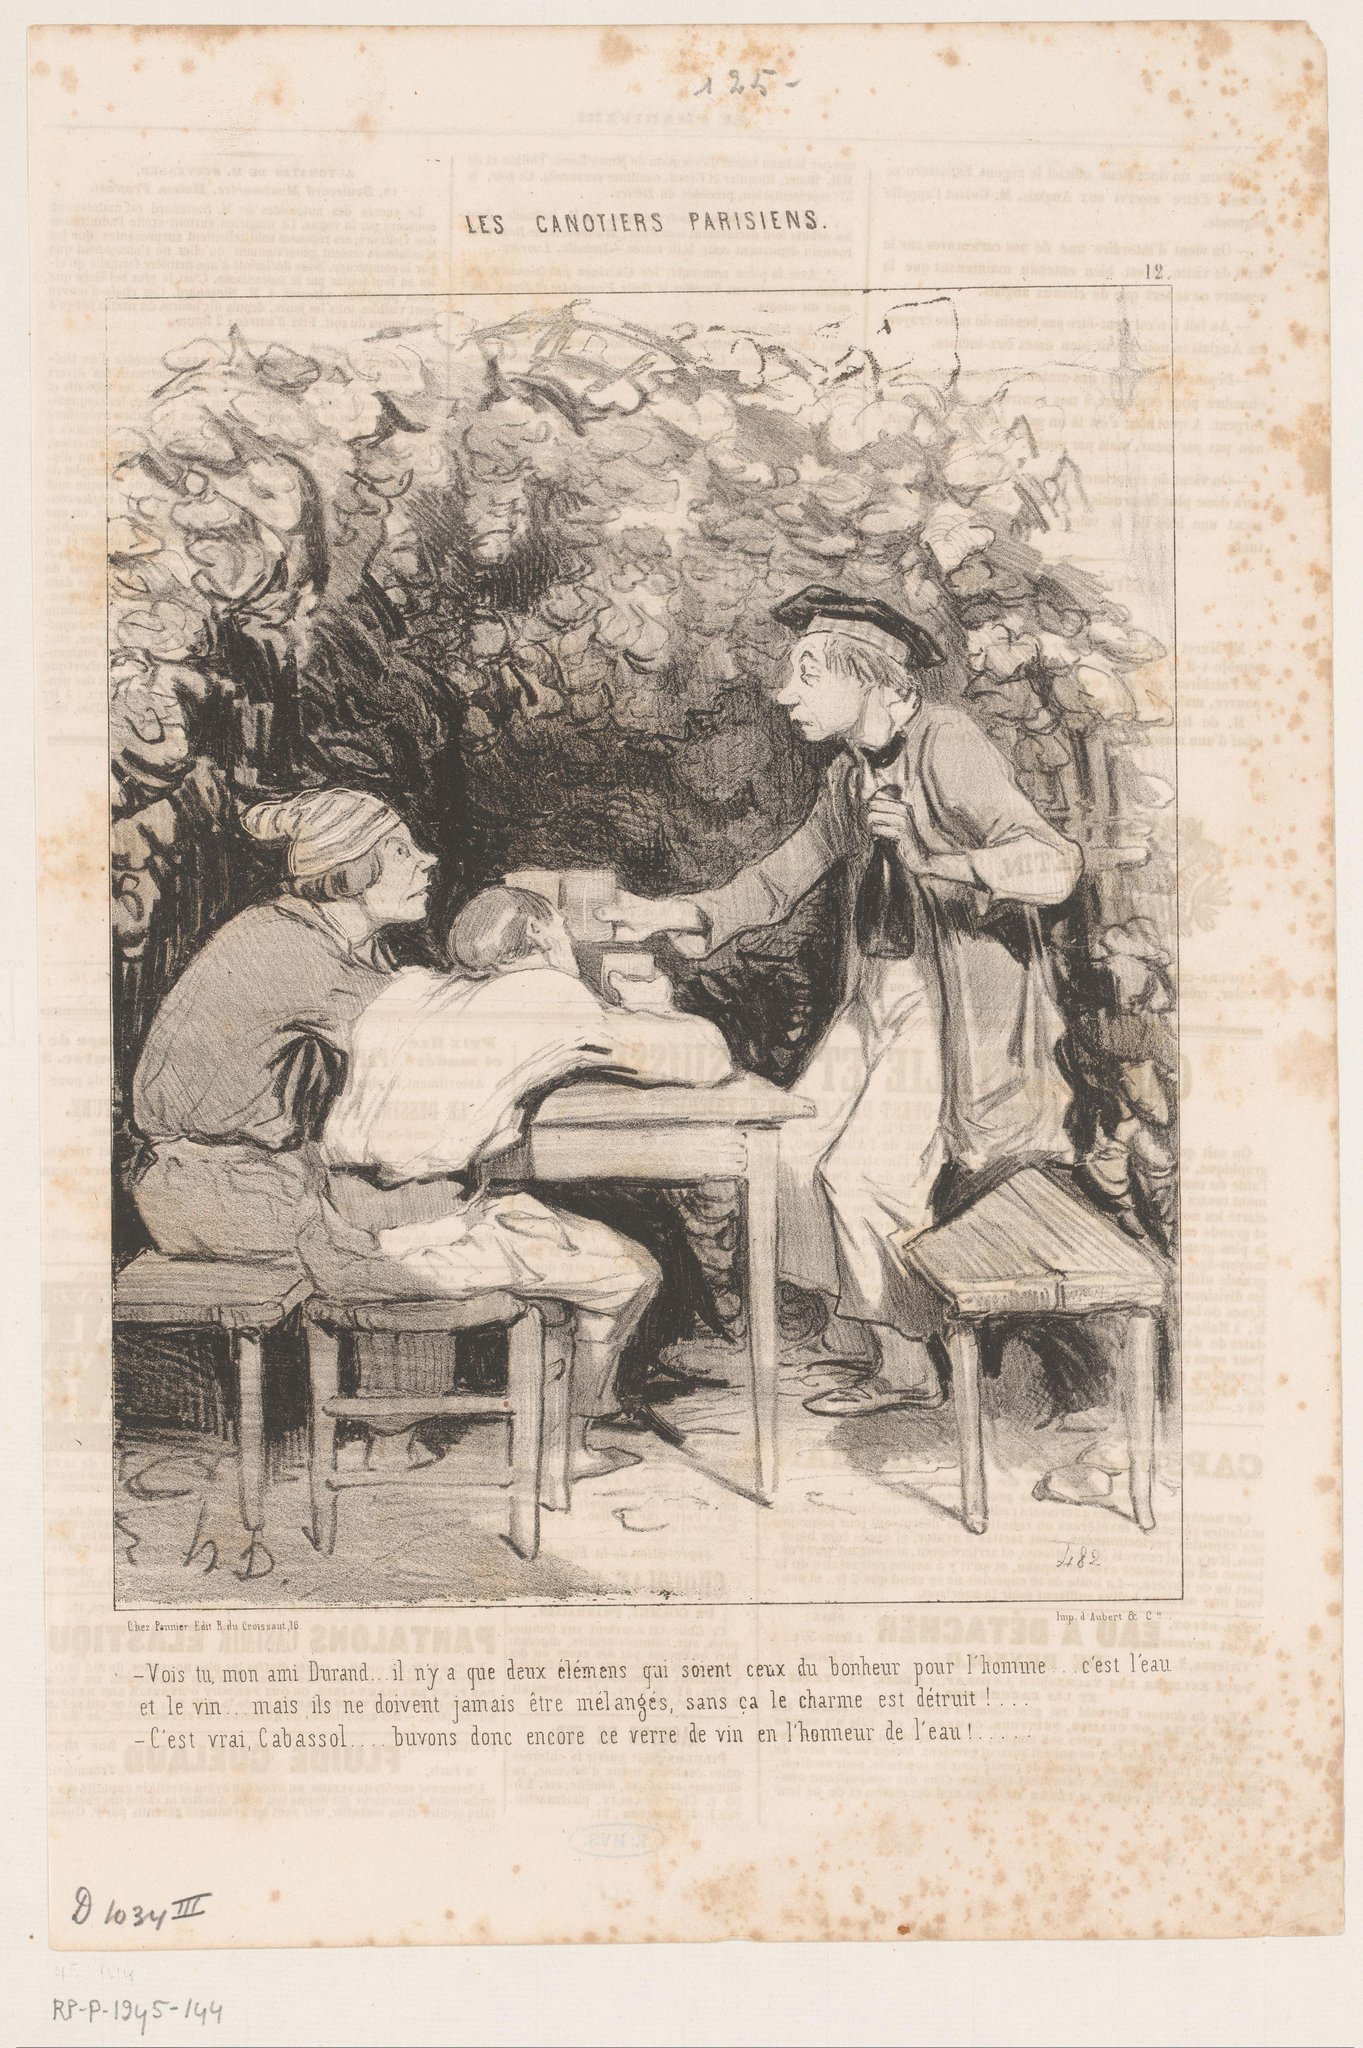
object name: cartoon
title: Parijse schippers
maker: honoré daumier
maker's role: draughtsman, painter, print maker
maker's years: 1808-1879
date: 1843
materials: paper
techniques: lithograph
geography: paris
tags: crew ~ ship, caricatures (human types), glass of wine, drinking, paris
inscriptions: collector's mark: Lugt 2228a, number: ‘125’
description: Prent gepubliceerd in: Le Charivari, Aubert: Parijs, 02-06-1843. Le Charivari was een humoristische krant met karikaturen en (politieke) cartoons.